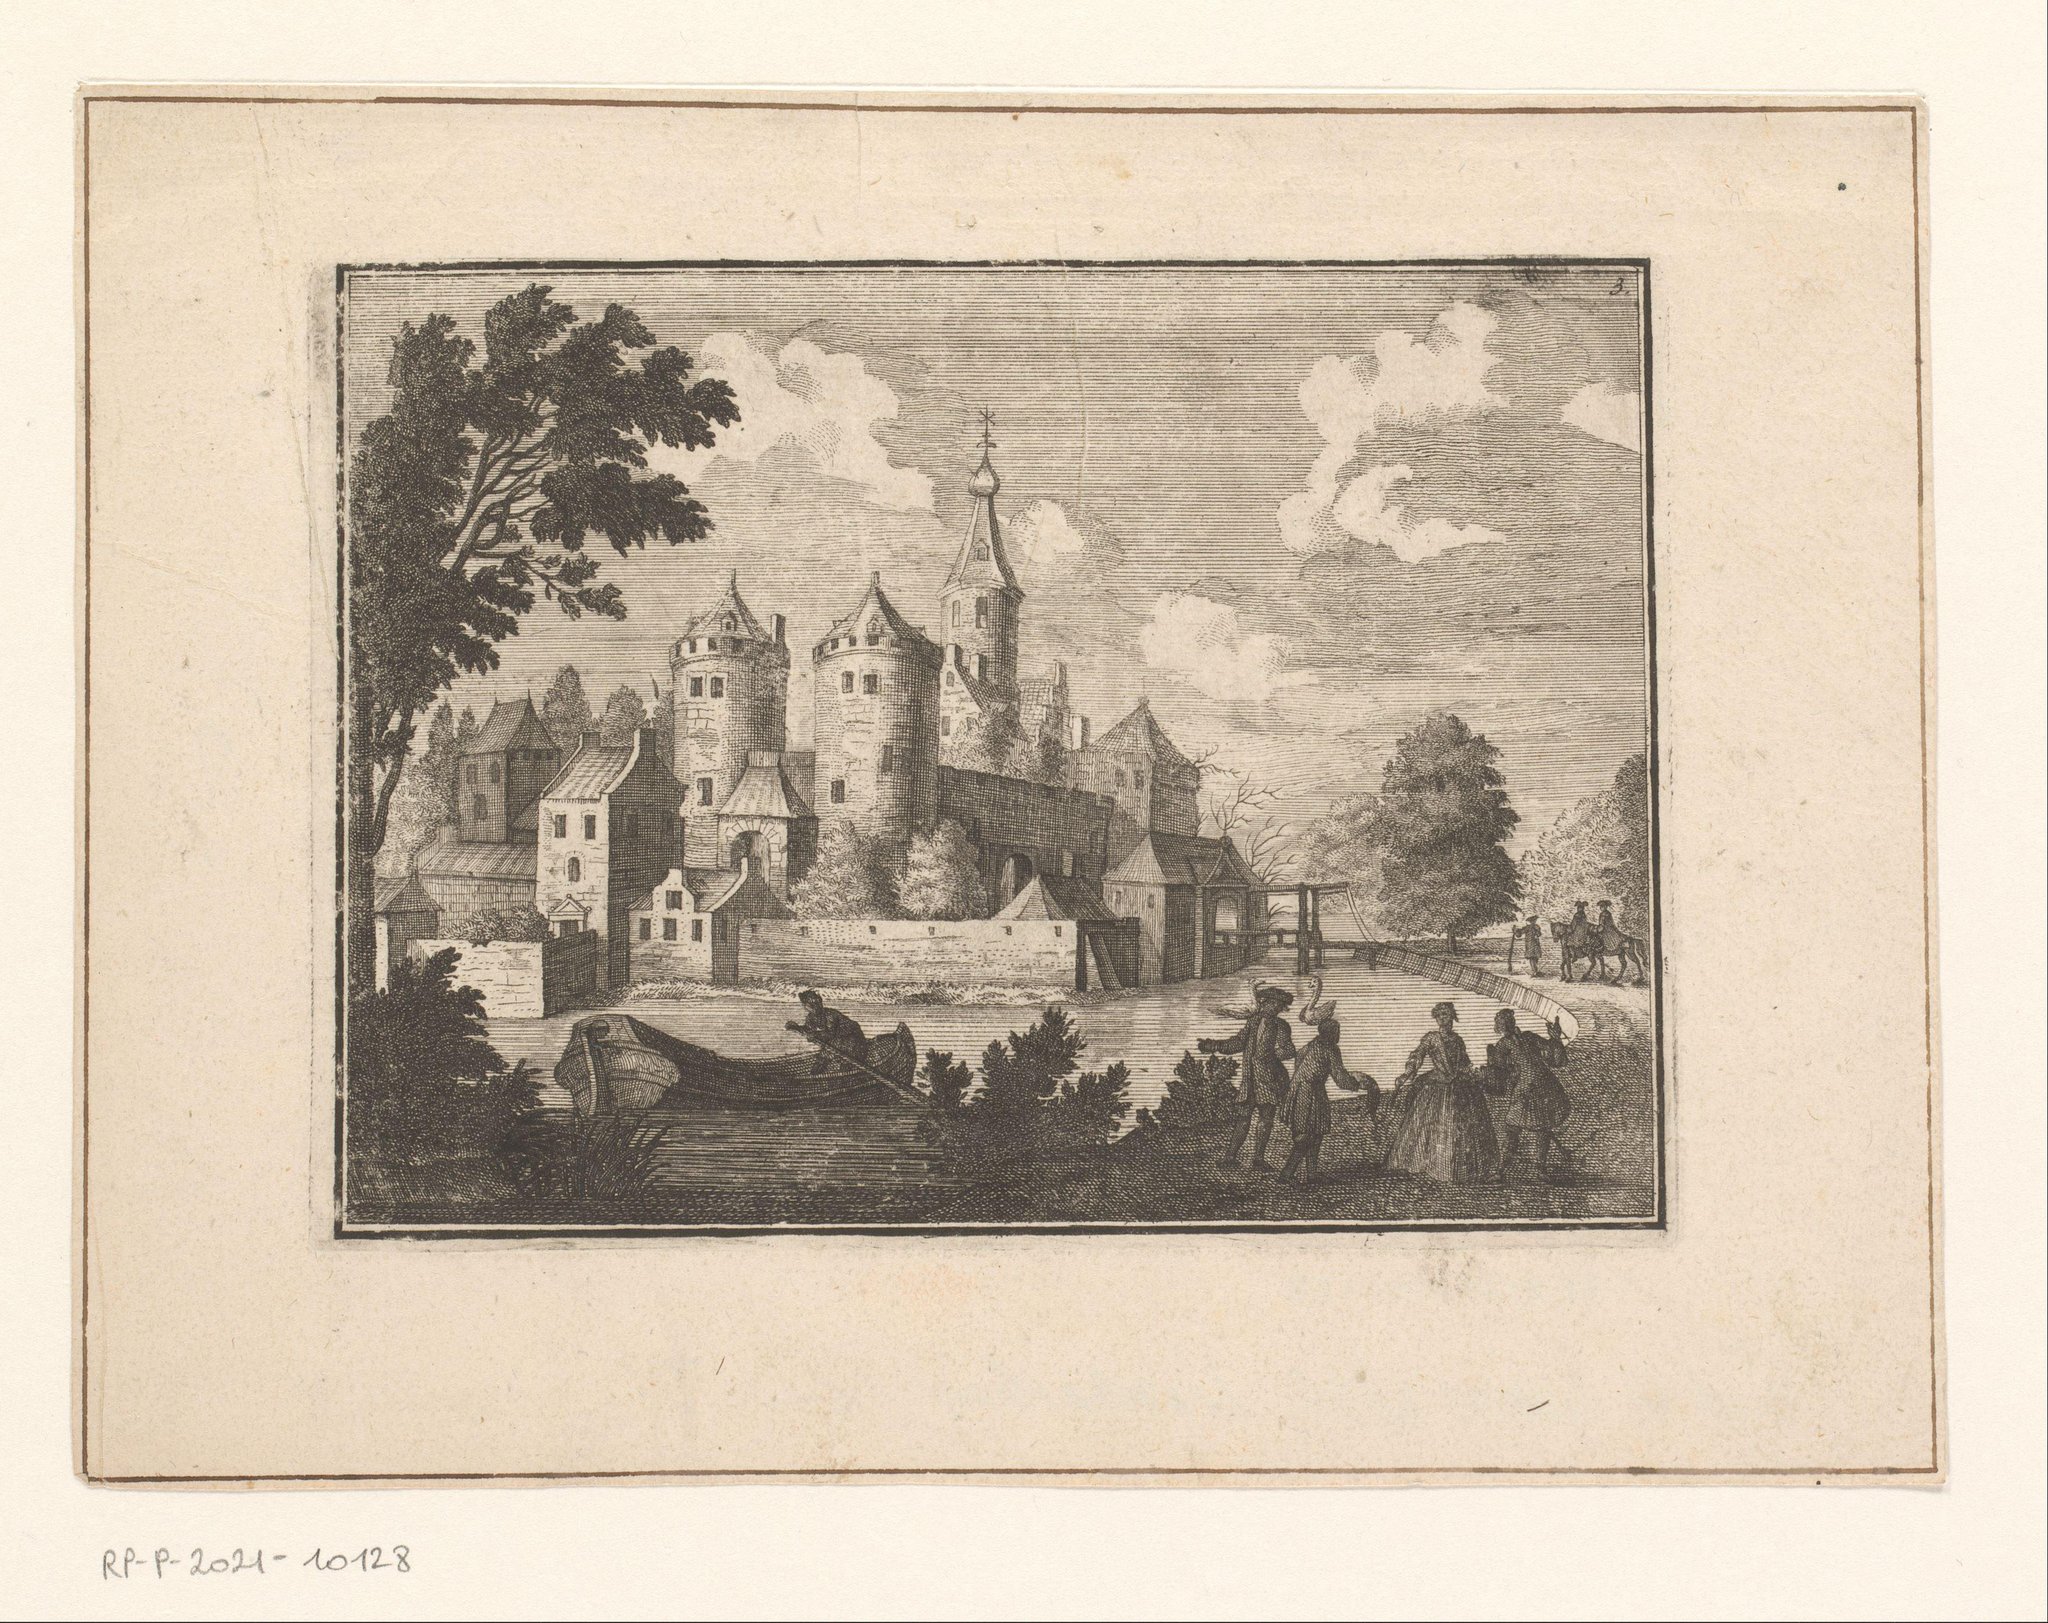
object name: print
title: Gezicht op een kasteel met slotgracht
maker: Anonymous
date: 1650-1750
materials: paper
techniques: etching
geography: low countries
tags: moat ~ fortified city, castle, water-birds: swan, rowing-boat, canoe, etc.